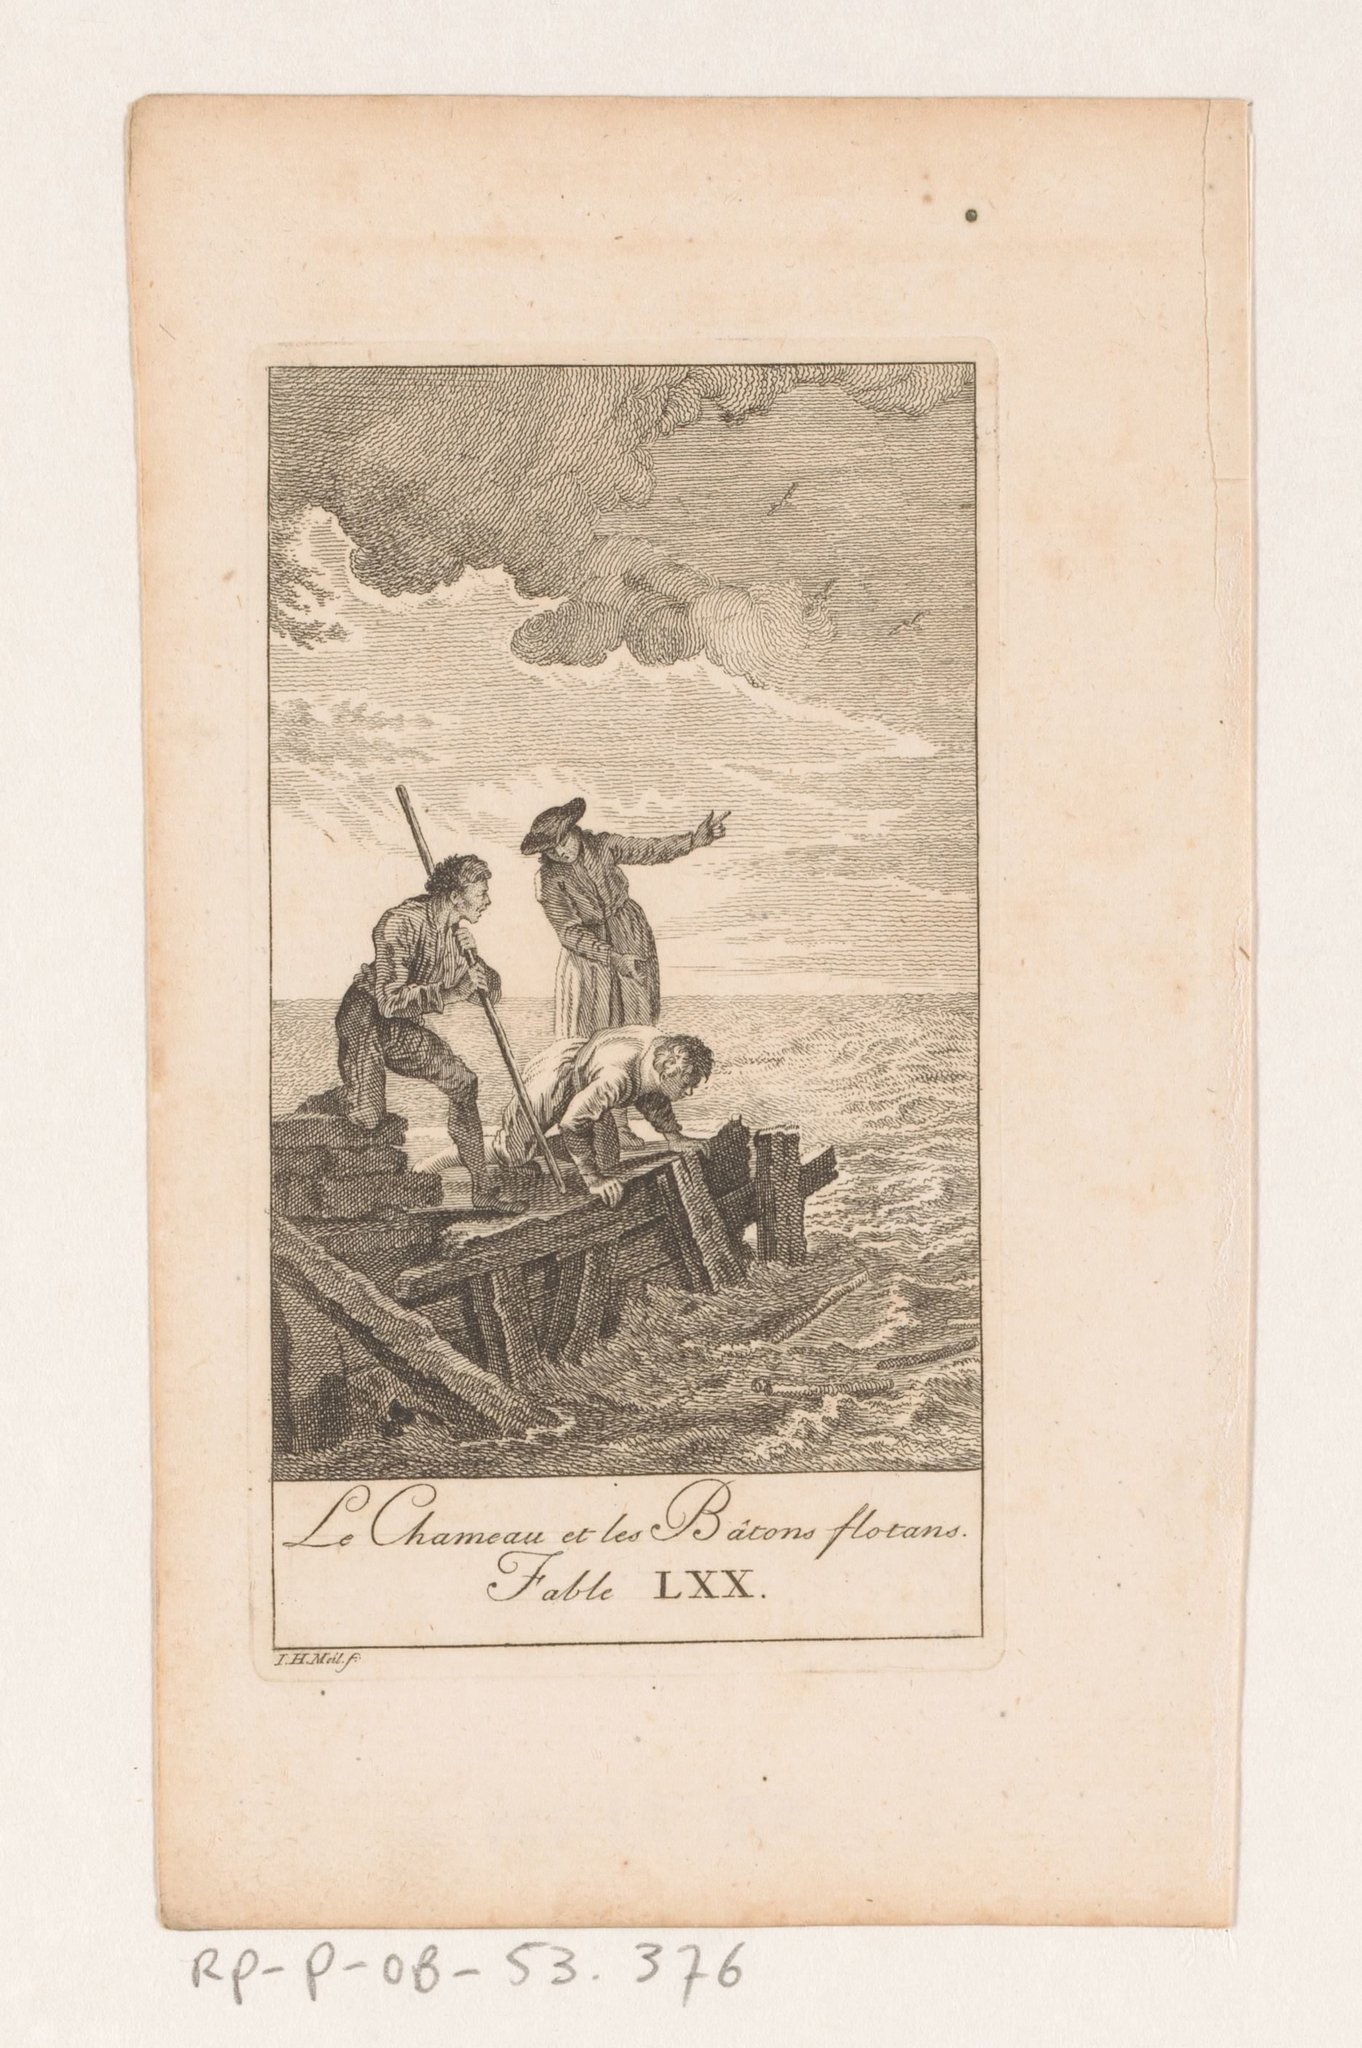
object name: print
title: Fabel van de drijvende stokken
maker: johann heinrich meil (der ältere)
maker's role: print maker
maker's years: 1730-1820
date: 1758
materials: paper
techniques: etching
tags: fables of lafontaine : use 85(...), floating (movement in water)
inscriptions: collector's mark: Lugt 2228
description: Illustratie uit: Fontaine, J. de la. Fables choisies, mises en vers. Dl. 2. Dresden & Leipzig: George Conrad Walther, 1758.